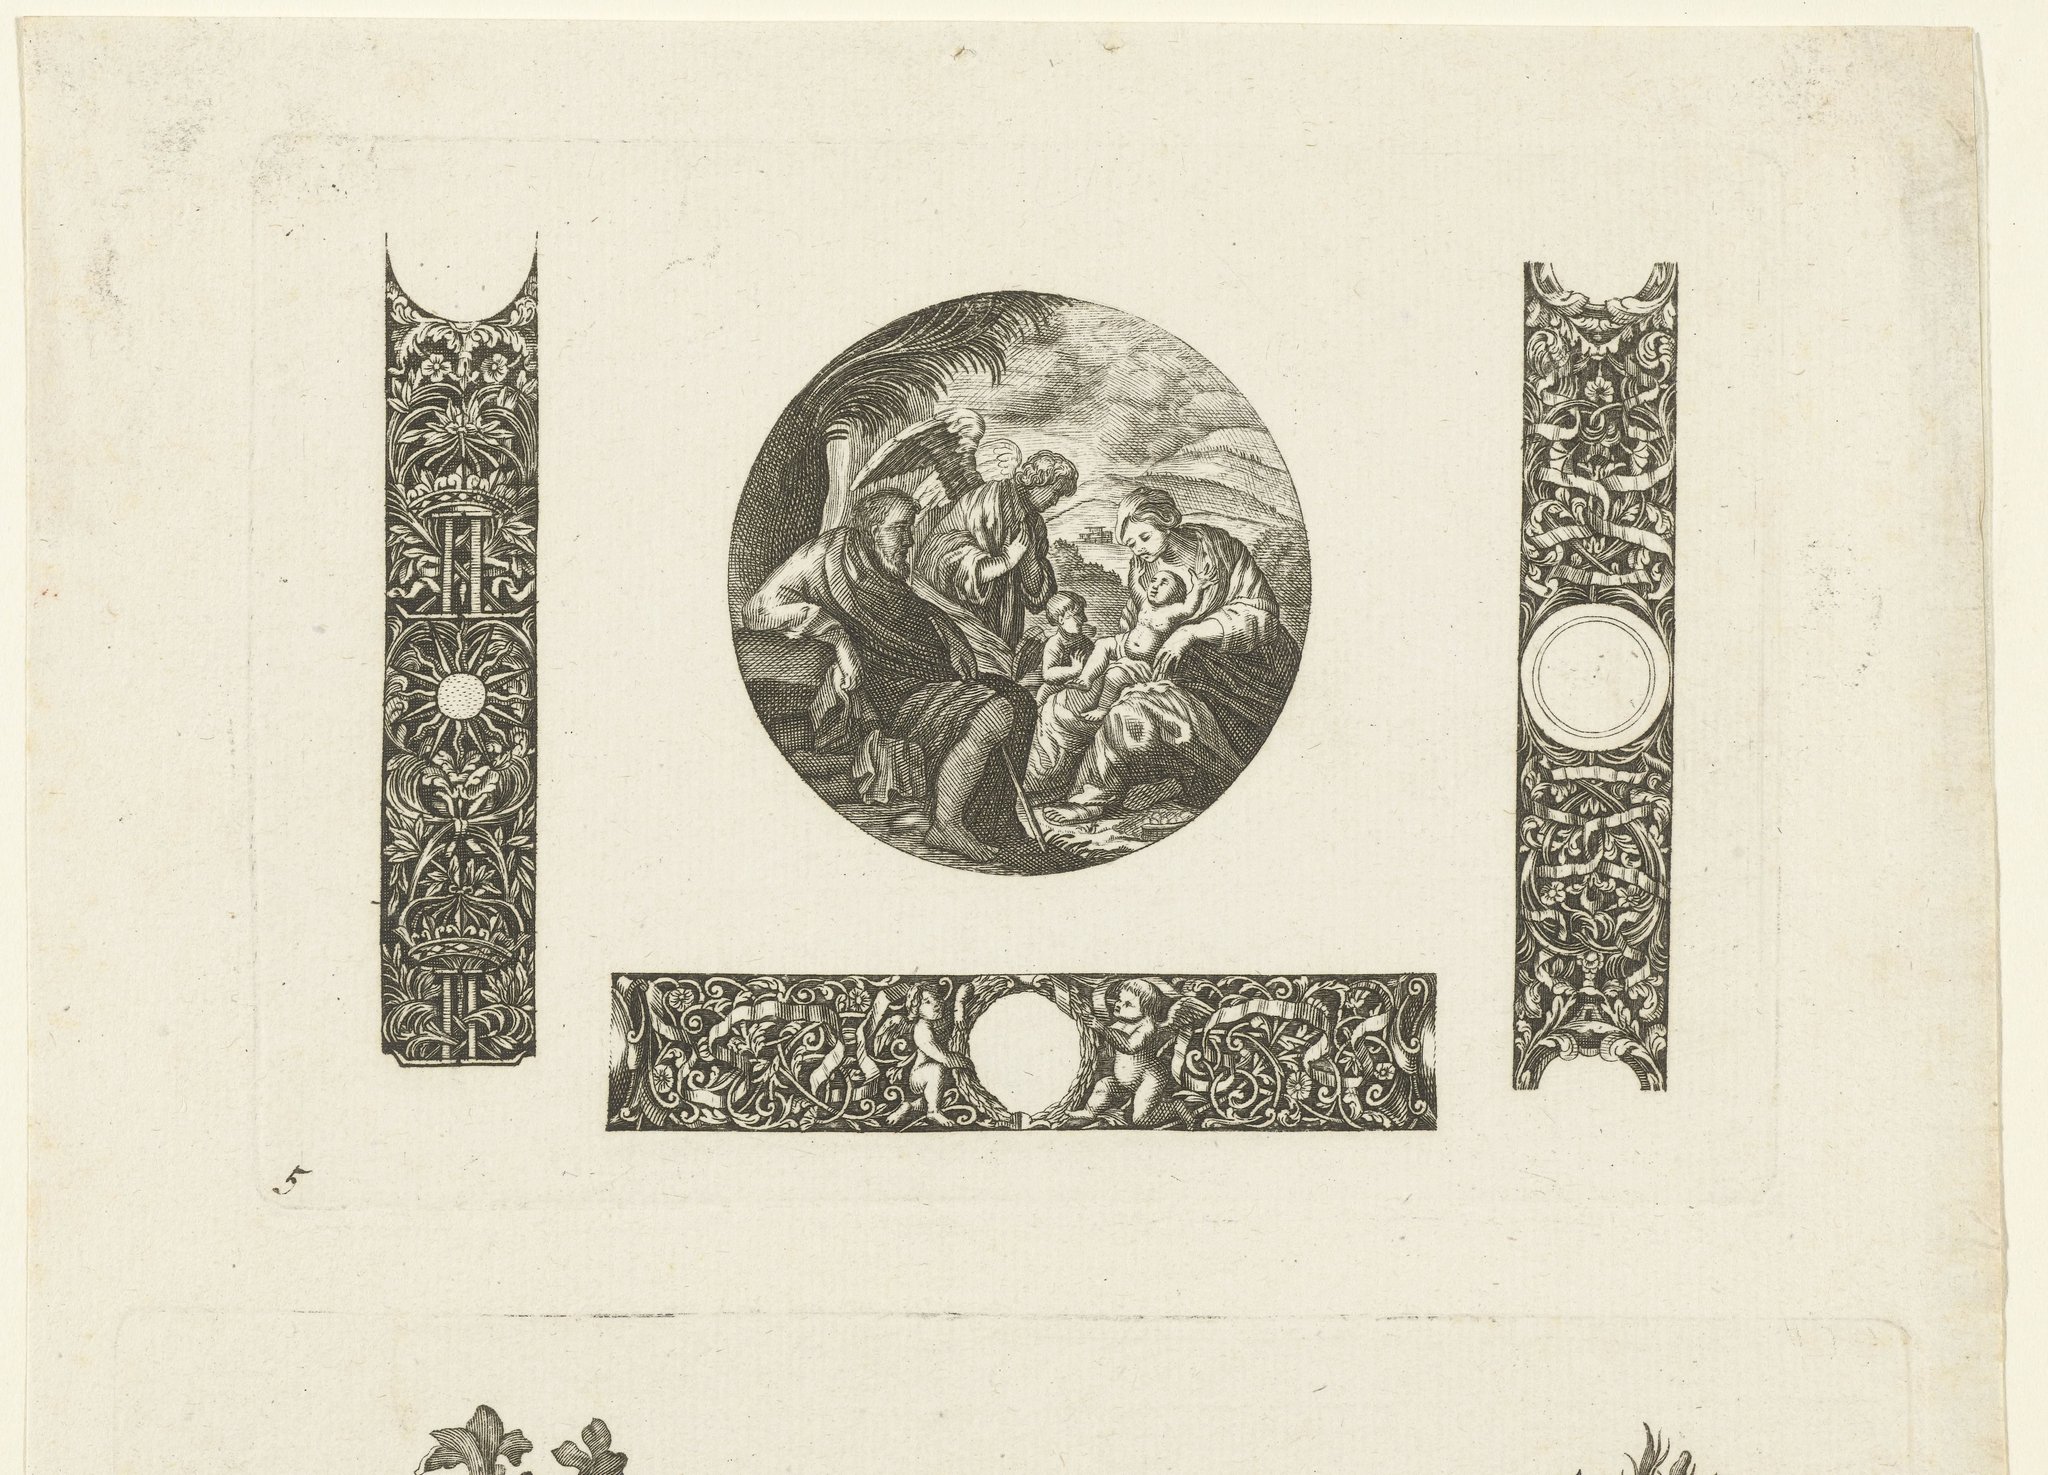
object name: ornament print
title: Horlogekast en drie stroken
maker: Anonymous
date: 1631-1736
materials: paper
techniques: engraving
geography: france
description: Horlogekast met de Heilige Familie, een engel en Johannes de Doper.